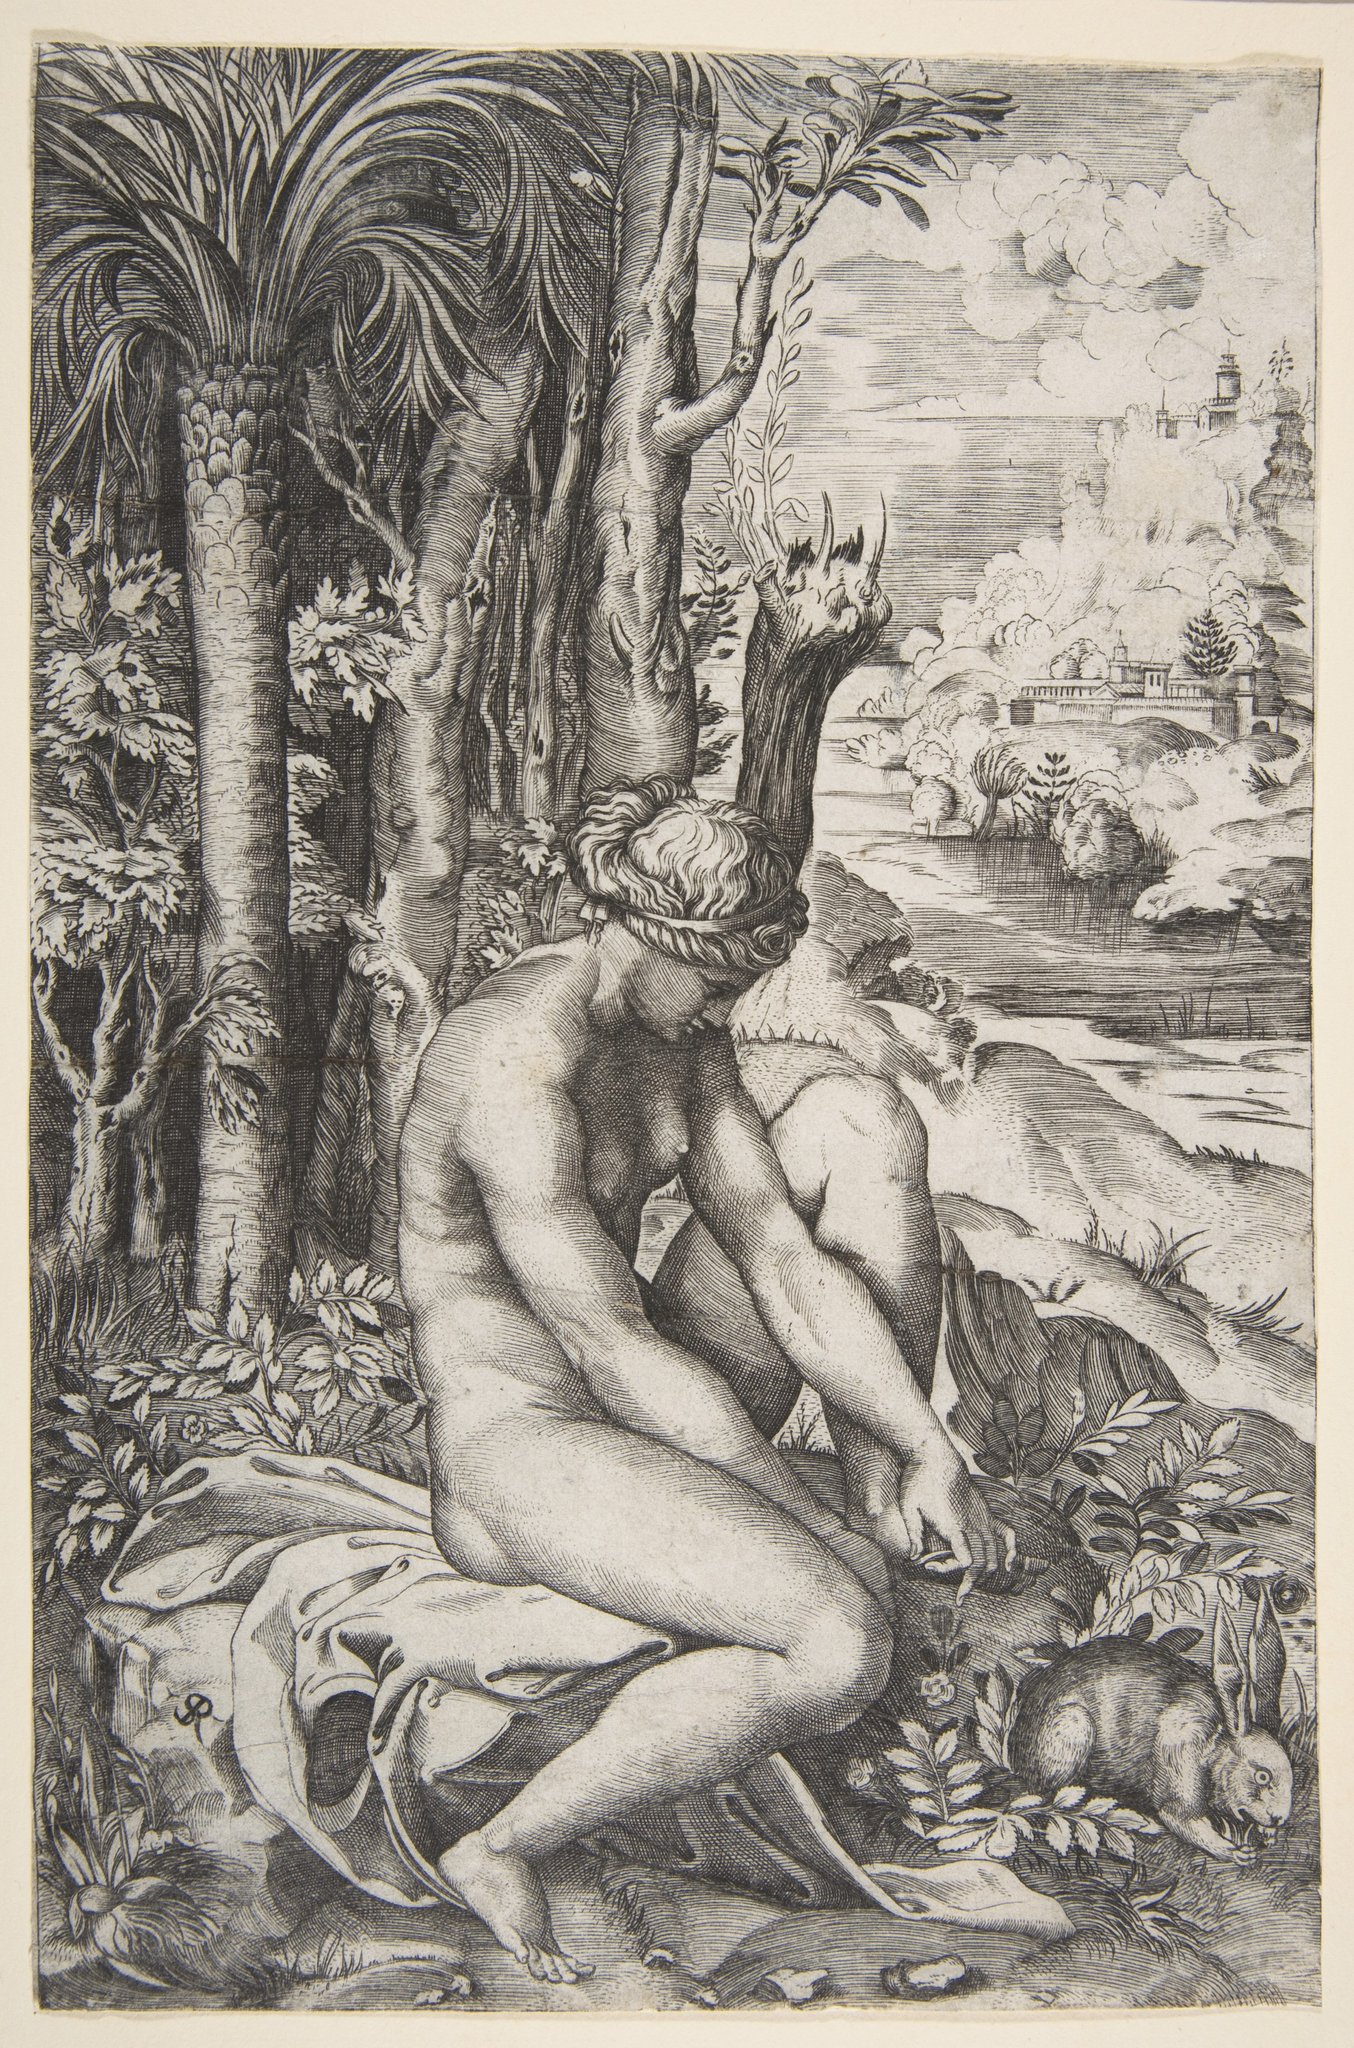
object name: print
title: Venus removing a thorn from her left foot while seated on a cloth next to trees, a hare lower right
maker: marco dente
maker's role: artist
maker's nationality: italian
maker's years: 1515-1527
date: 1515-1527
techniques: engraving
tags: venus,rabbits